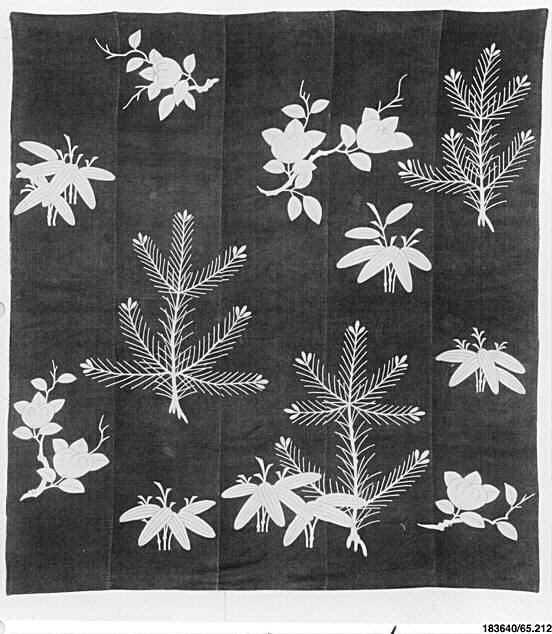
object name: cover, quilt futon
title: Cover (Futon)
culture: japanese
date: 1801-1833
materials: silk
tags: flowers